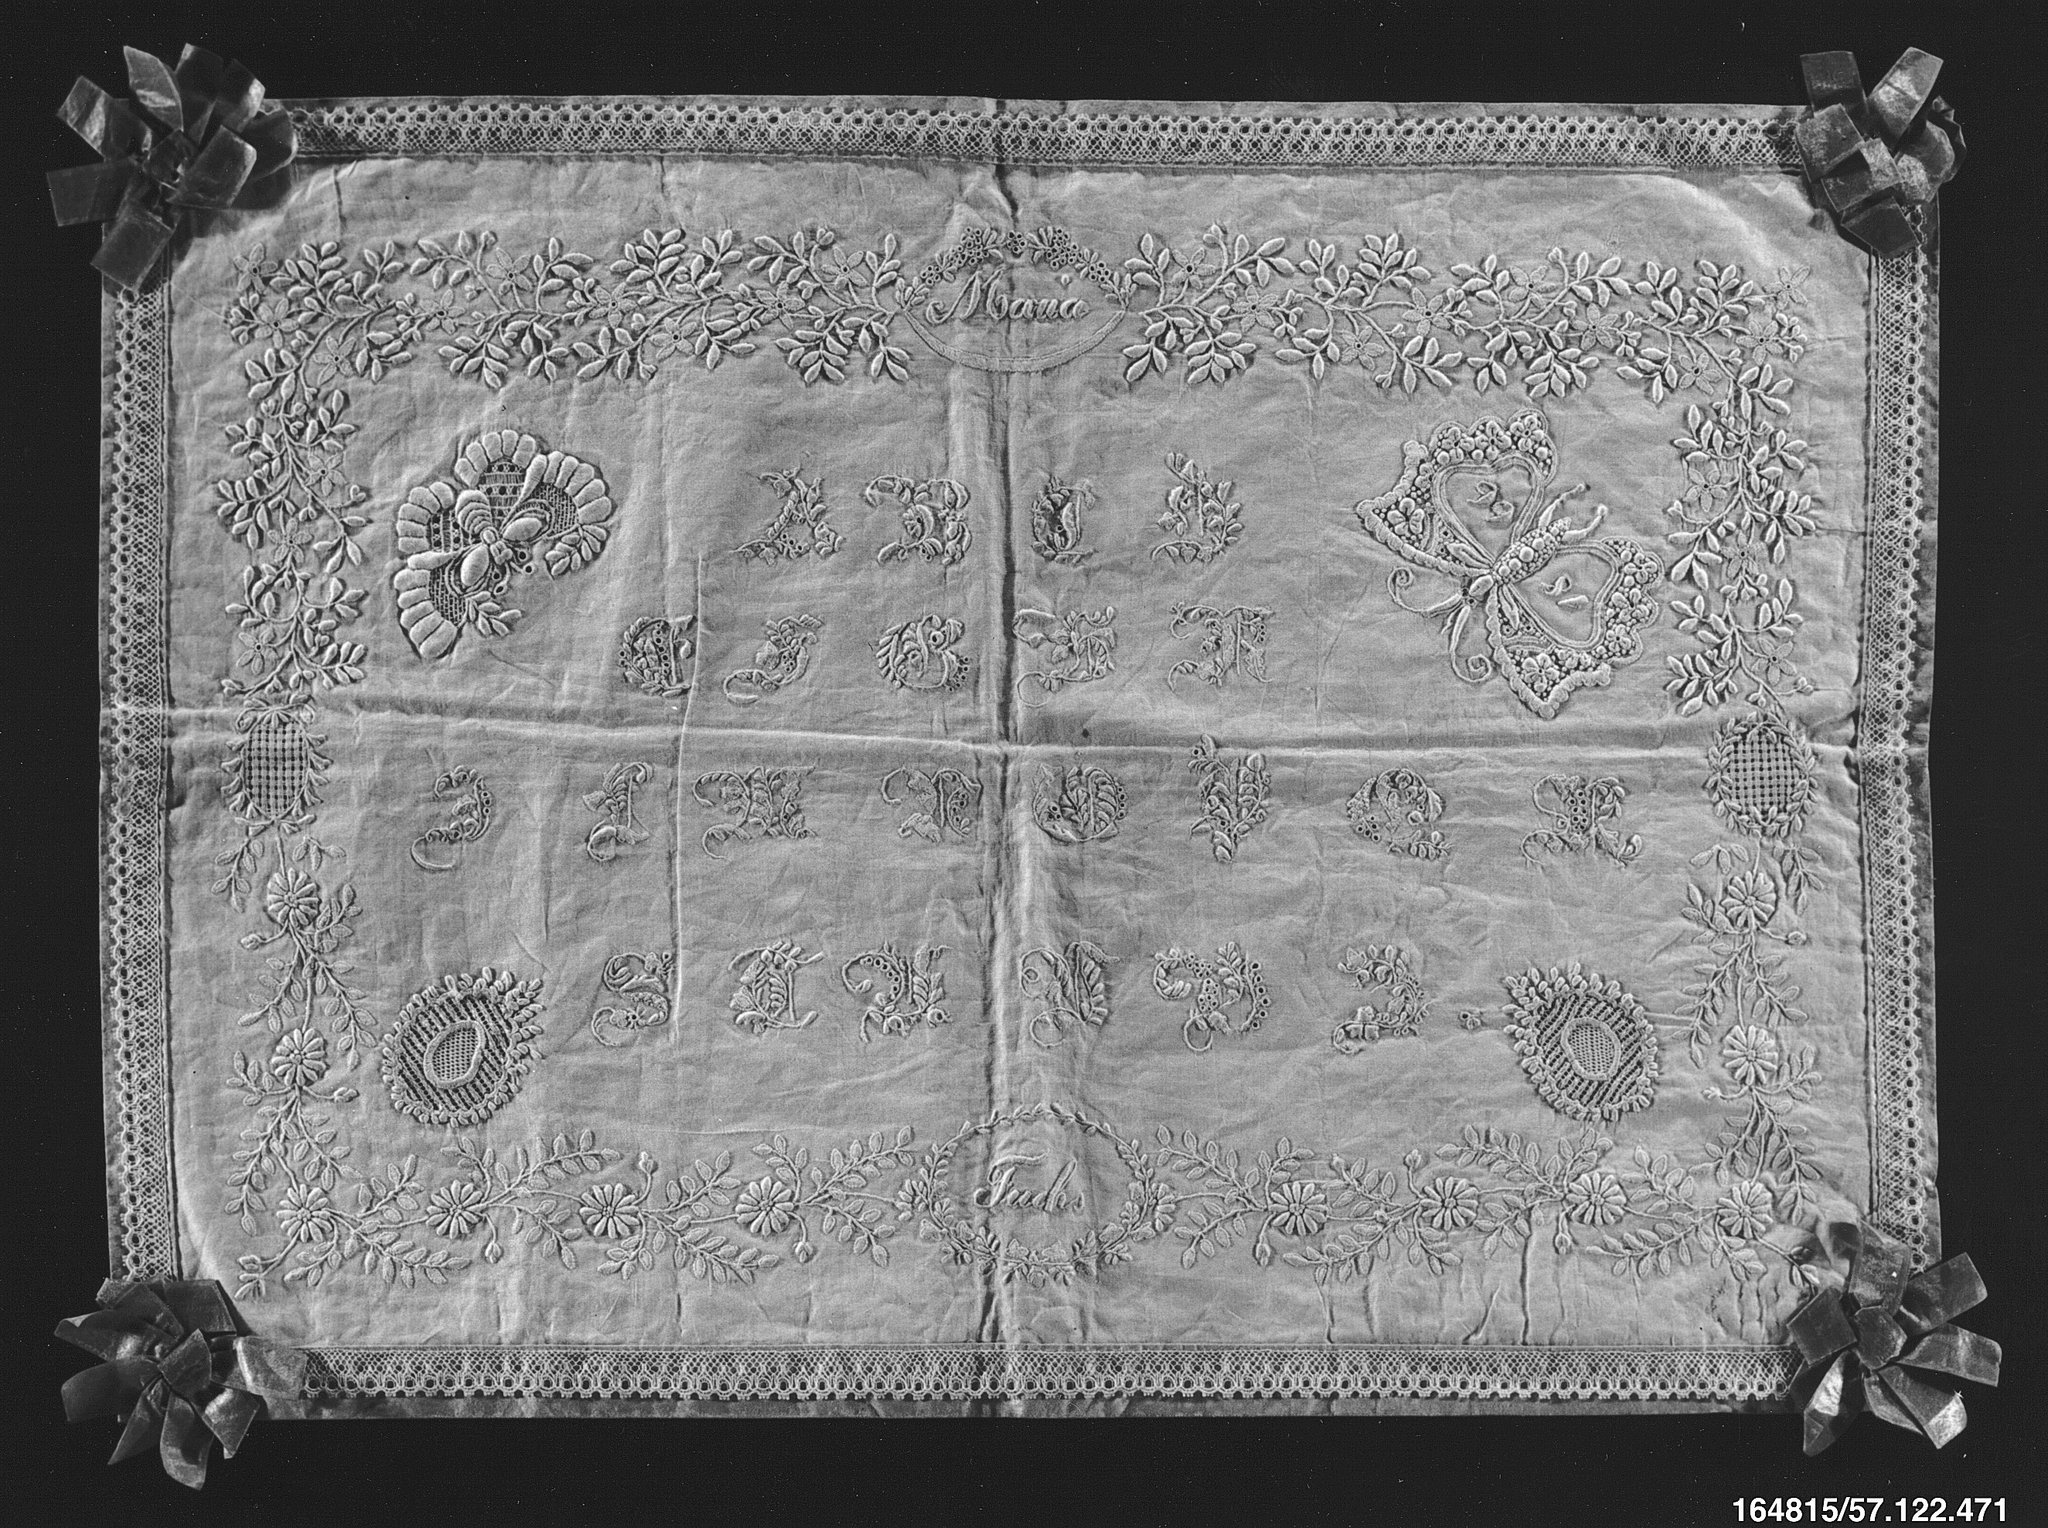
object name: sampler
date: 1866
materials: cotton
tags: butterflies,flowers